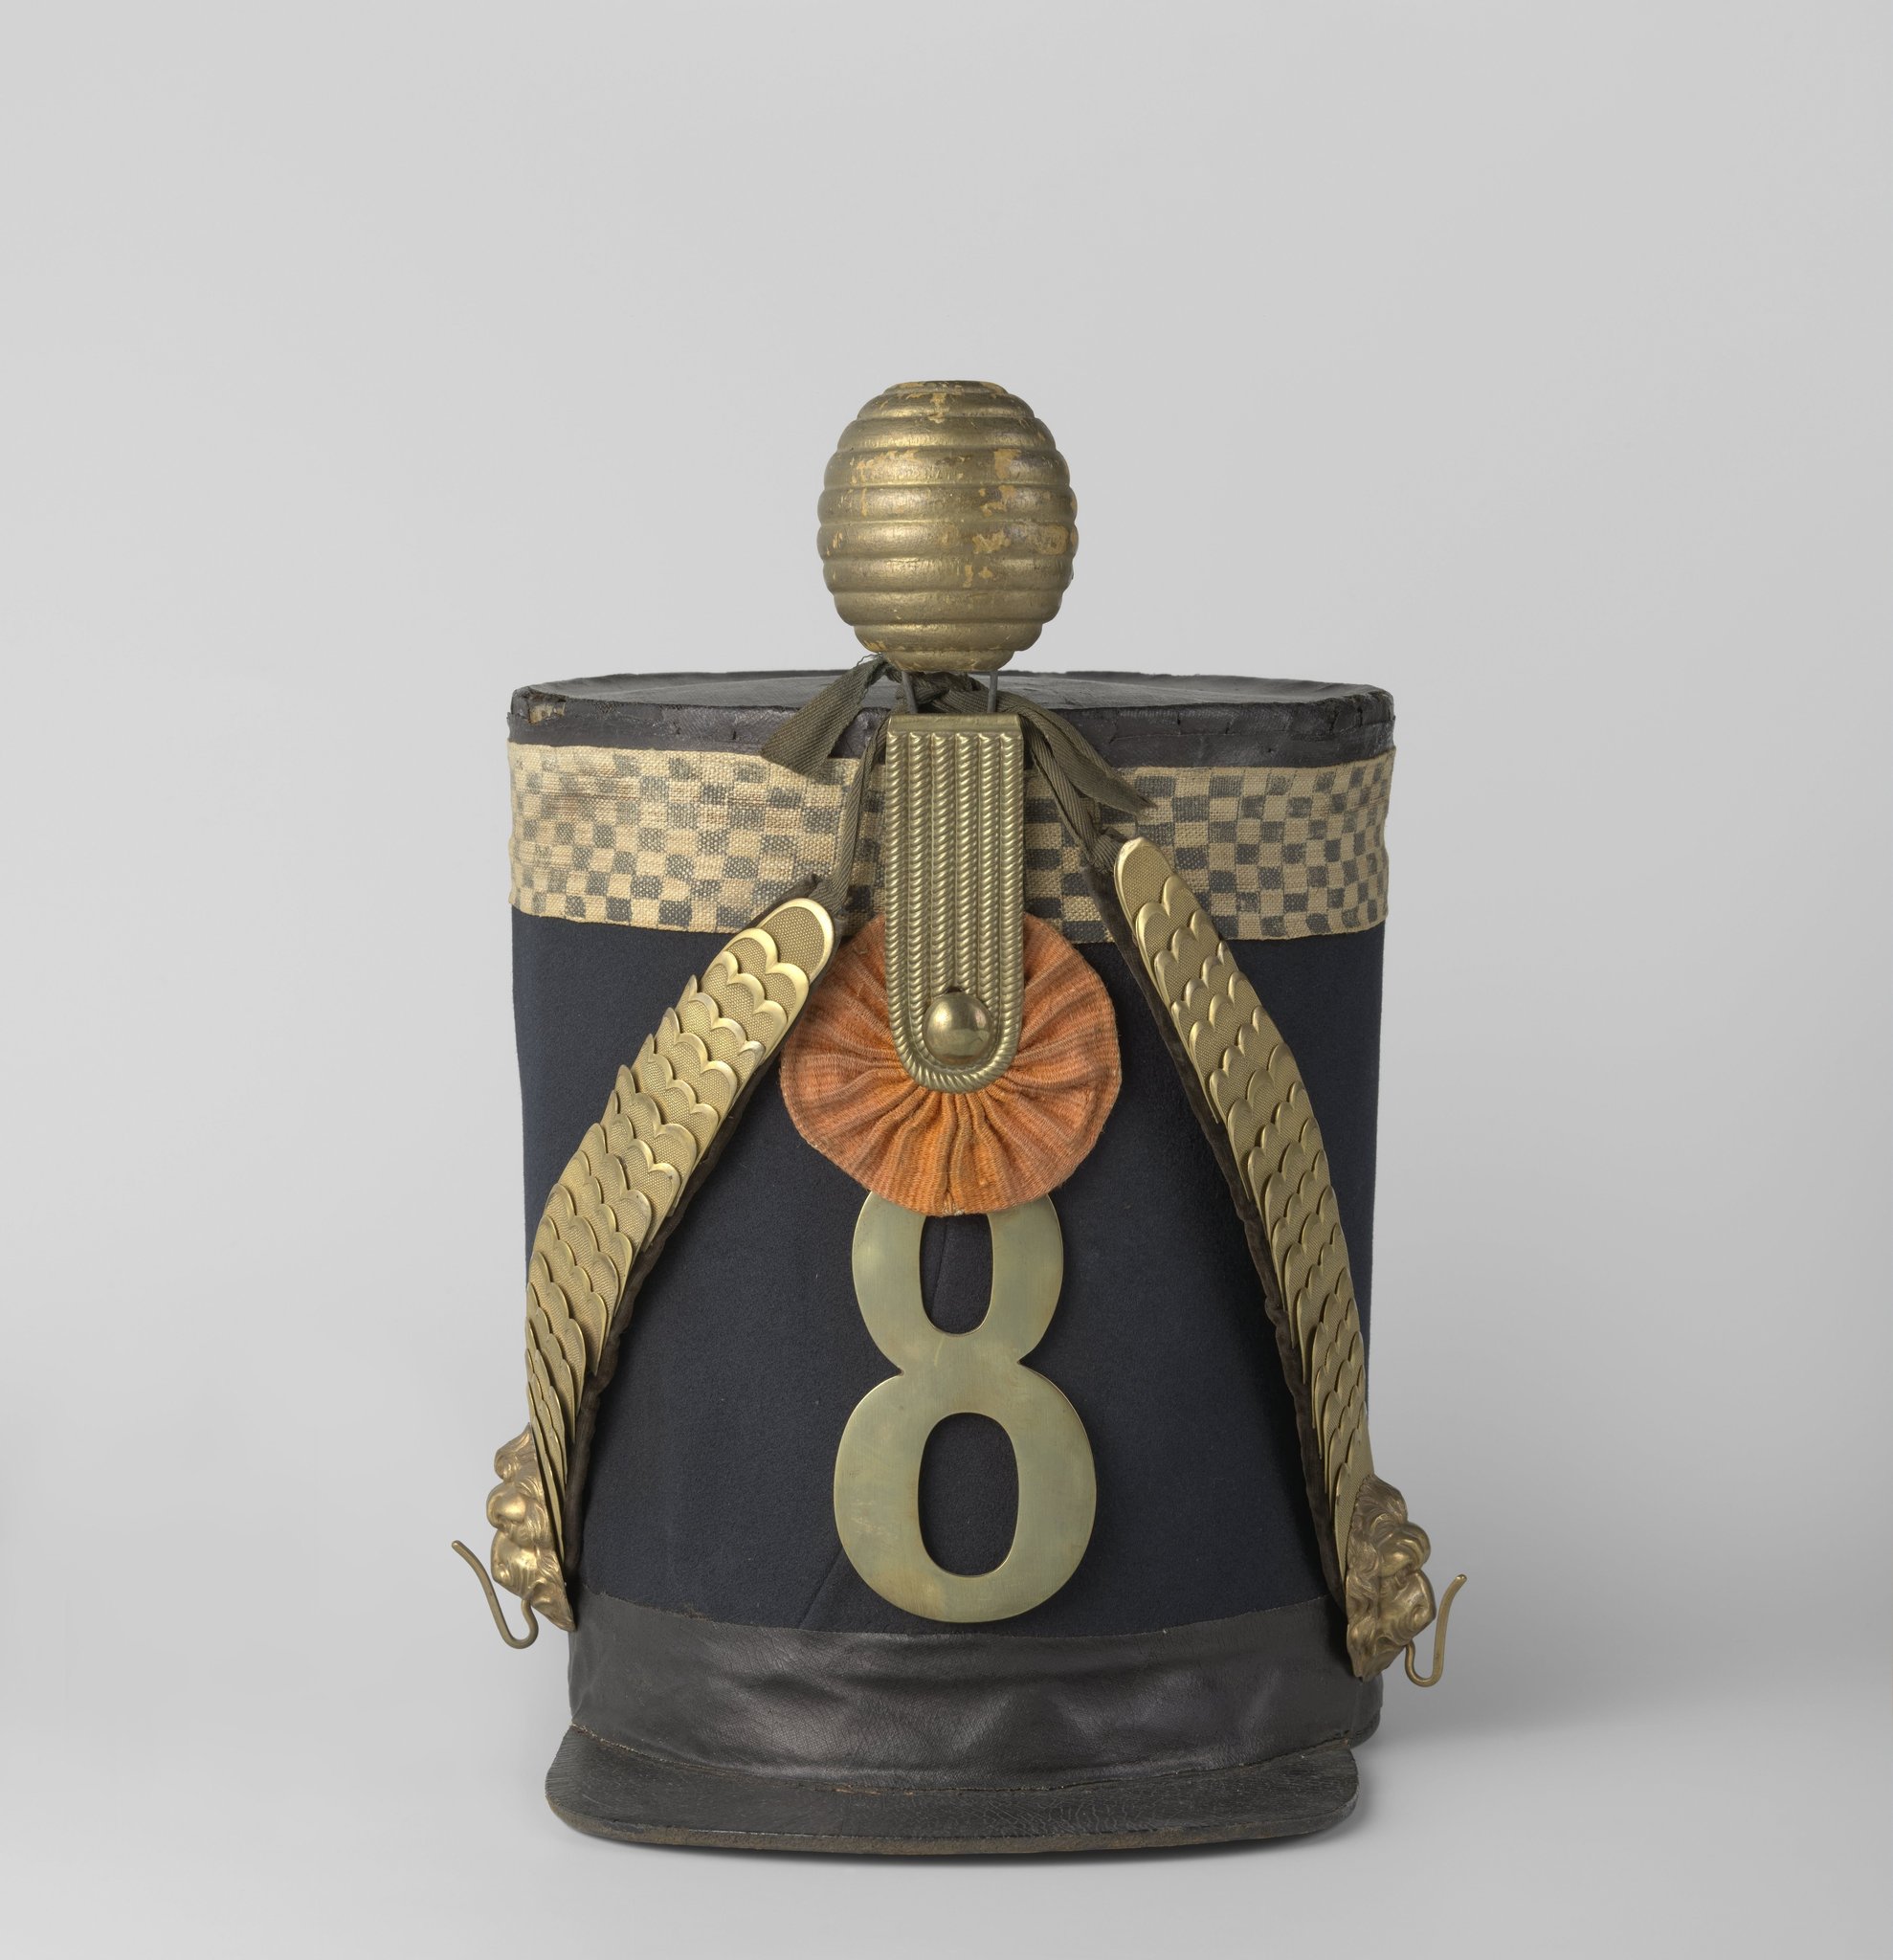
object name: hoofddeksel, hoofdbedekking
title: Sjako van het regiment Huzaren nr. 8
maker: Anonymous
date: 1800-1854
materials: textile, copper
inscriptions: : ‘8’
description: Sjako van blauw laken met koperen 8; stormband en pompon, oranje kokarde: van het regiment Huzaren nr. 8.